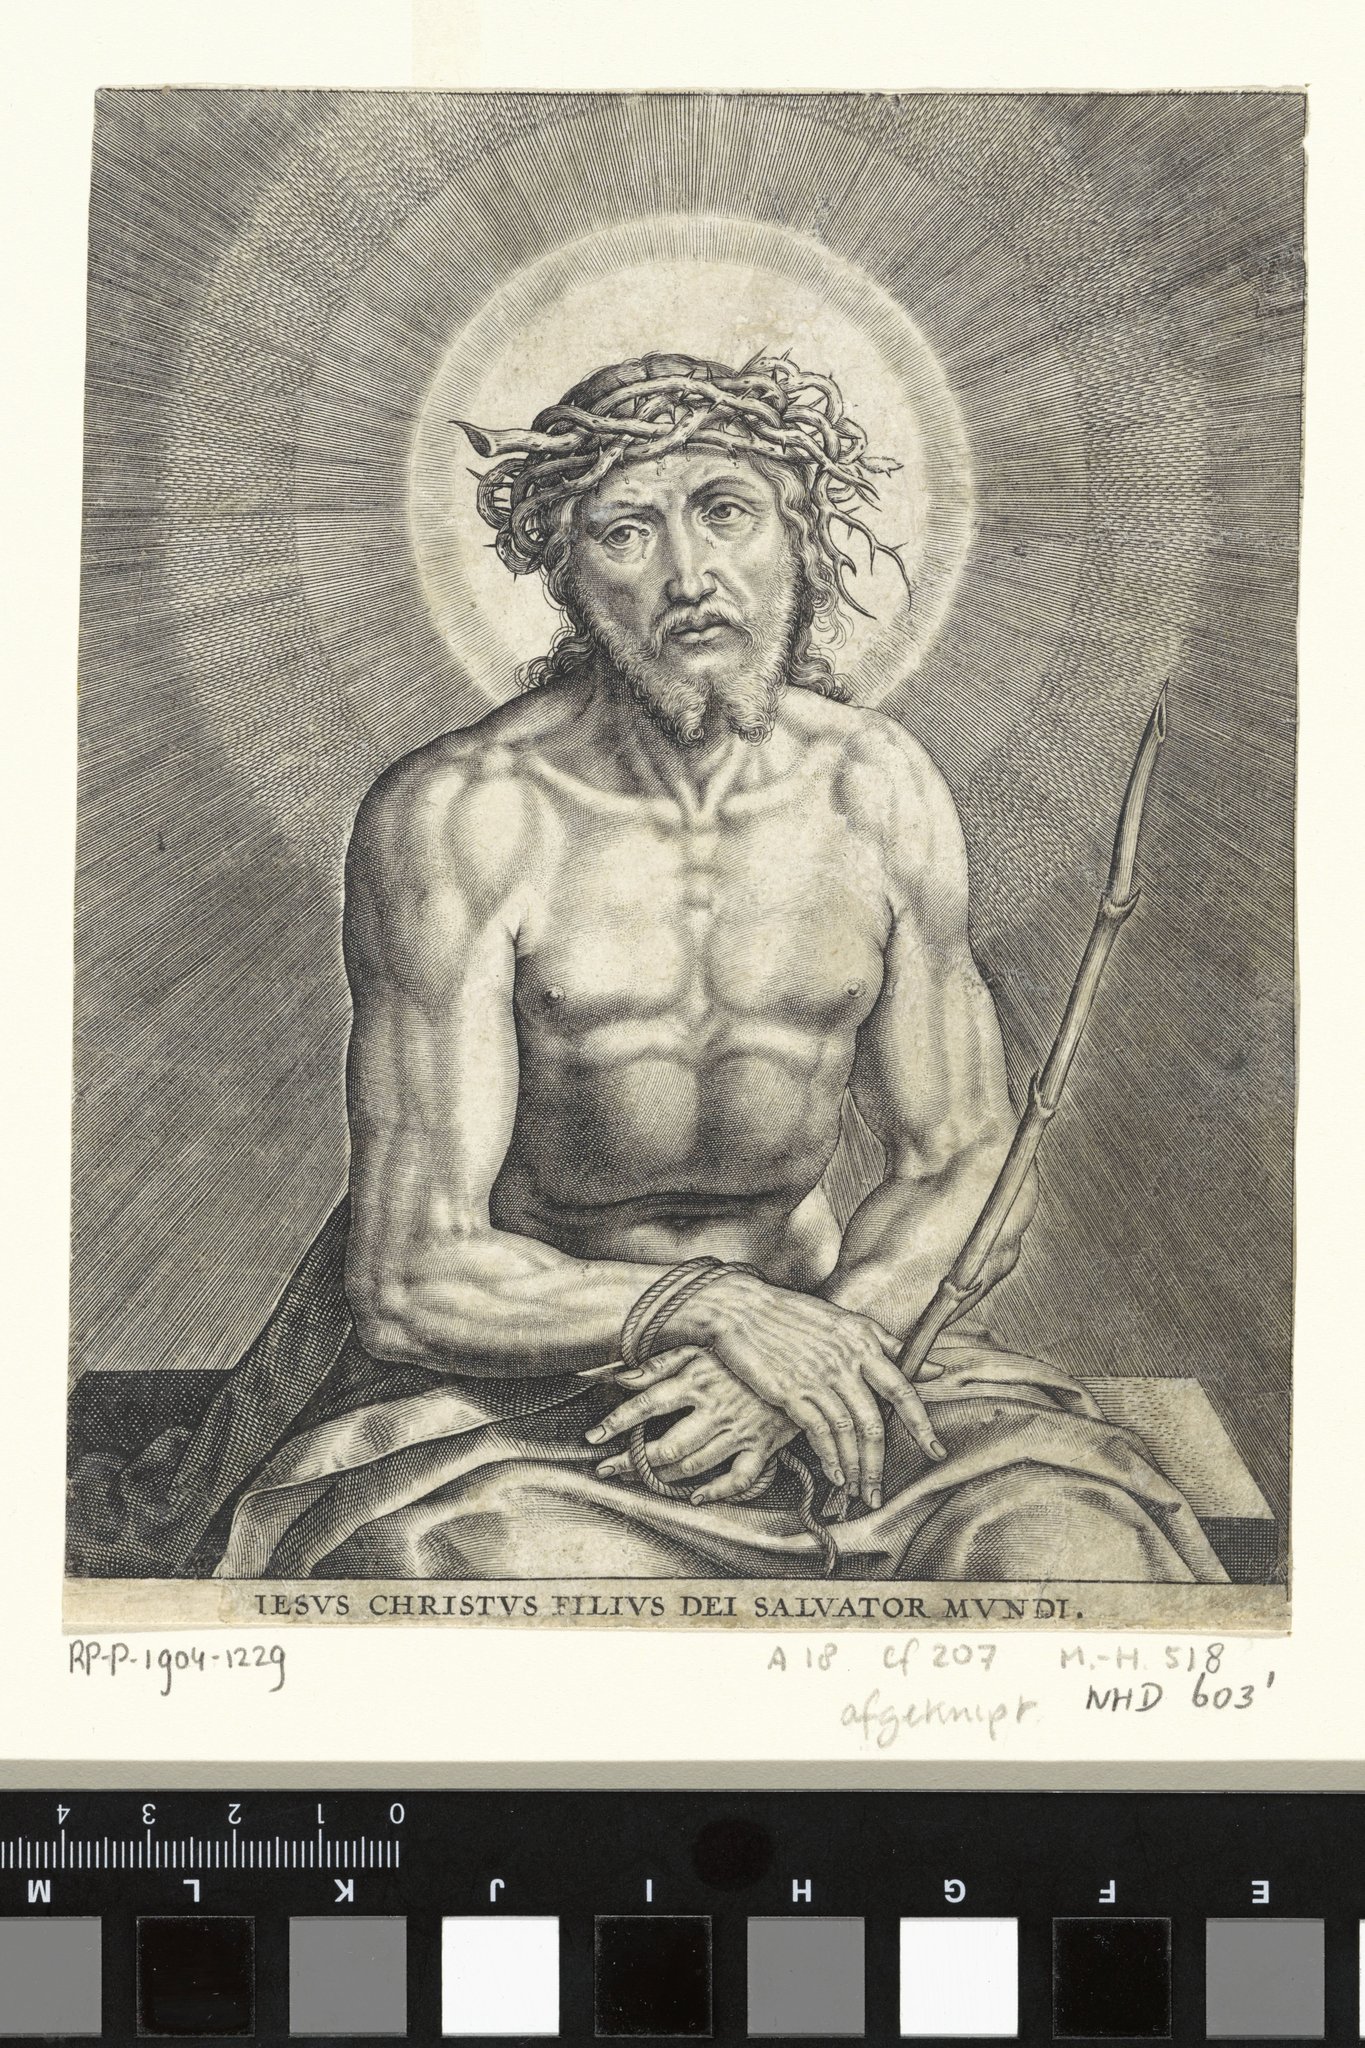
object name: print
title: Christus met doornenkroon (Ecce Homo)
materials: paper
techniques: engraving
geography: antwerp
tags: christ alone (also called 'ecce homo')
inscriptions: collector's mark: Lugt 2228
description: Christus zit op een bank, zijn handen geboeid, en op zijn hoofd de doornenkroon. Achter zijn hoofd een aureool. In zijn hand houdt hij een rietstengel.